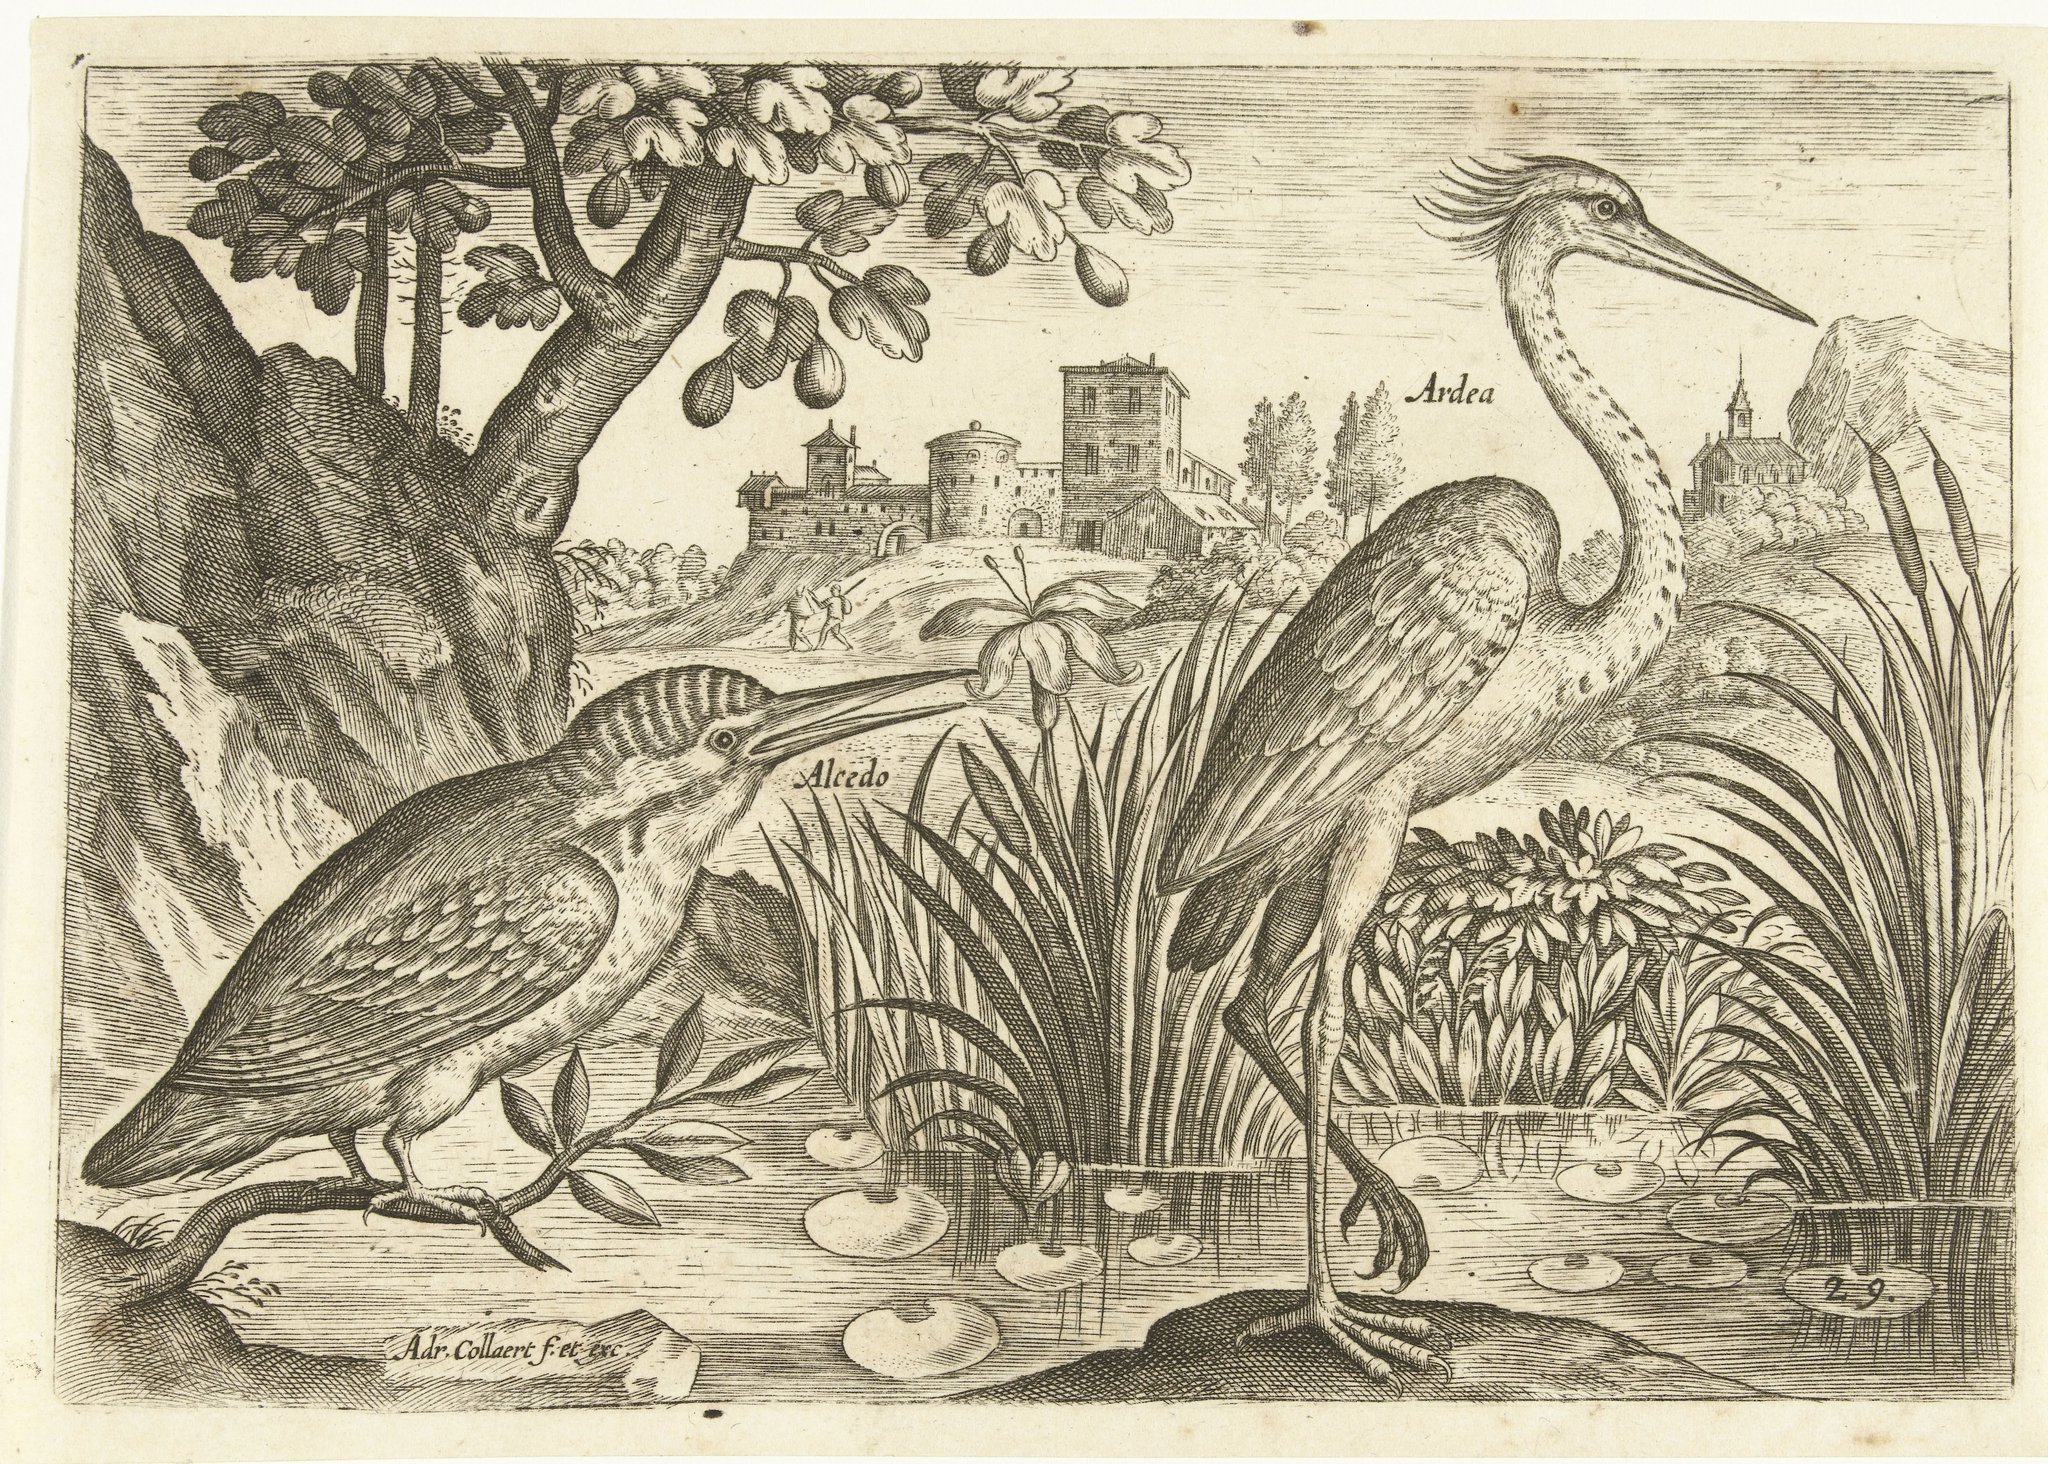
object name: print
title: Vogels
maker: adriaen collaert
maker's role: draughtsman, print maker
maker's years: 1560-1618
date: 1598-1602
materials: paper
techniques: engraving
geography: antwerp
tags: shore-birds and wading-birds: heron, pond, landscape with tower or castle (+ city(-scape) with figures, staffage), other birds: kingfisher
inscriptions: collector's mark: Lugt 2228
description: Een ijsvogel (Alcedo atthis) en een blauwe reiger (Ardea cinerea) in een vijver. op de achtergrond een vesting. De prent maakt deel uit van een serie met vogels als onderwerp.